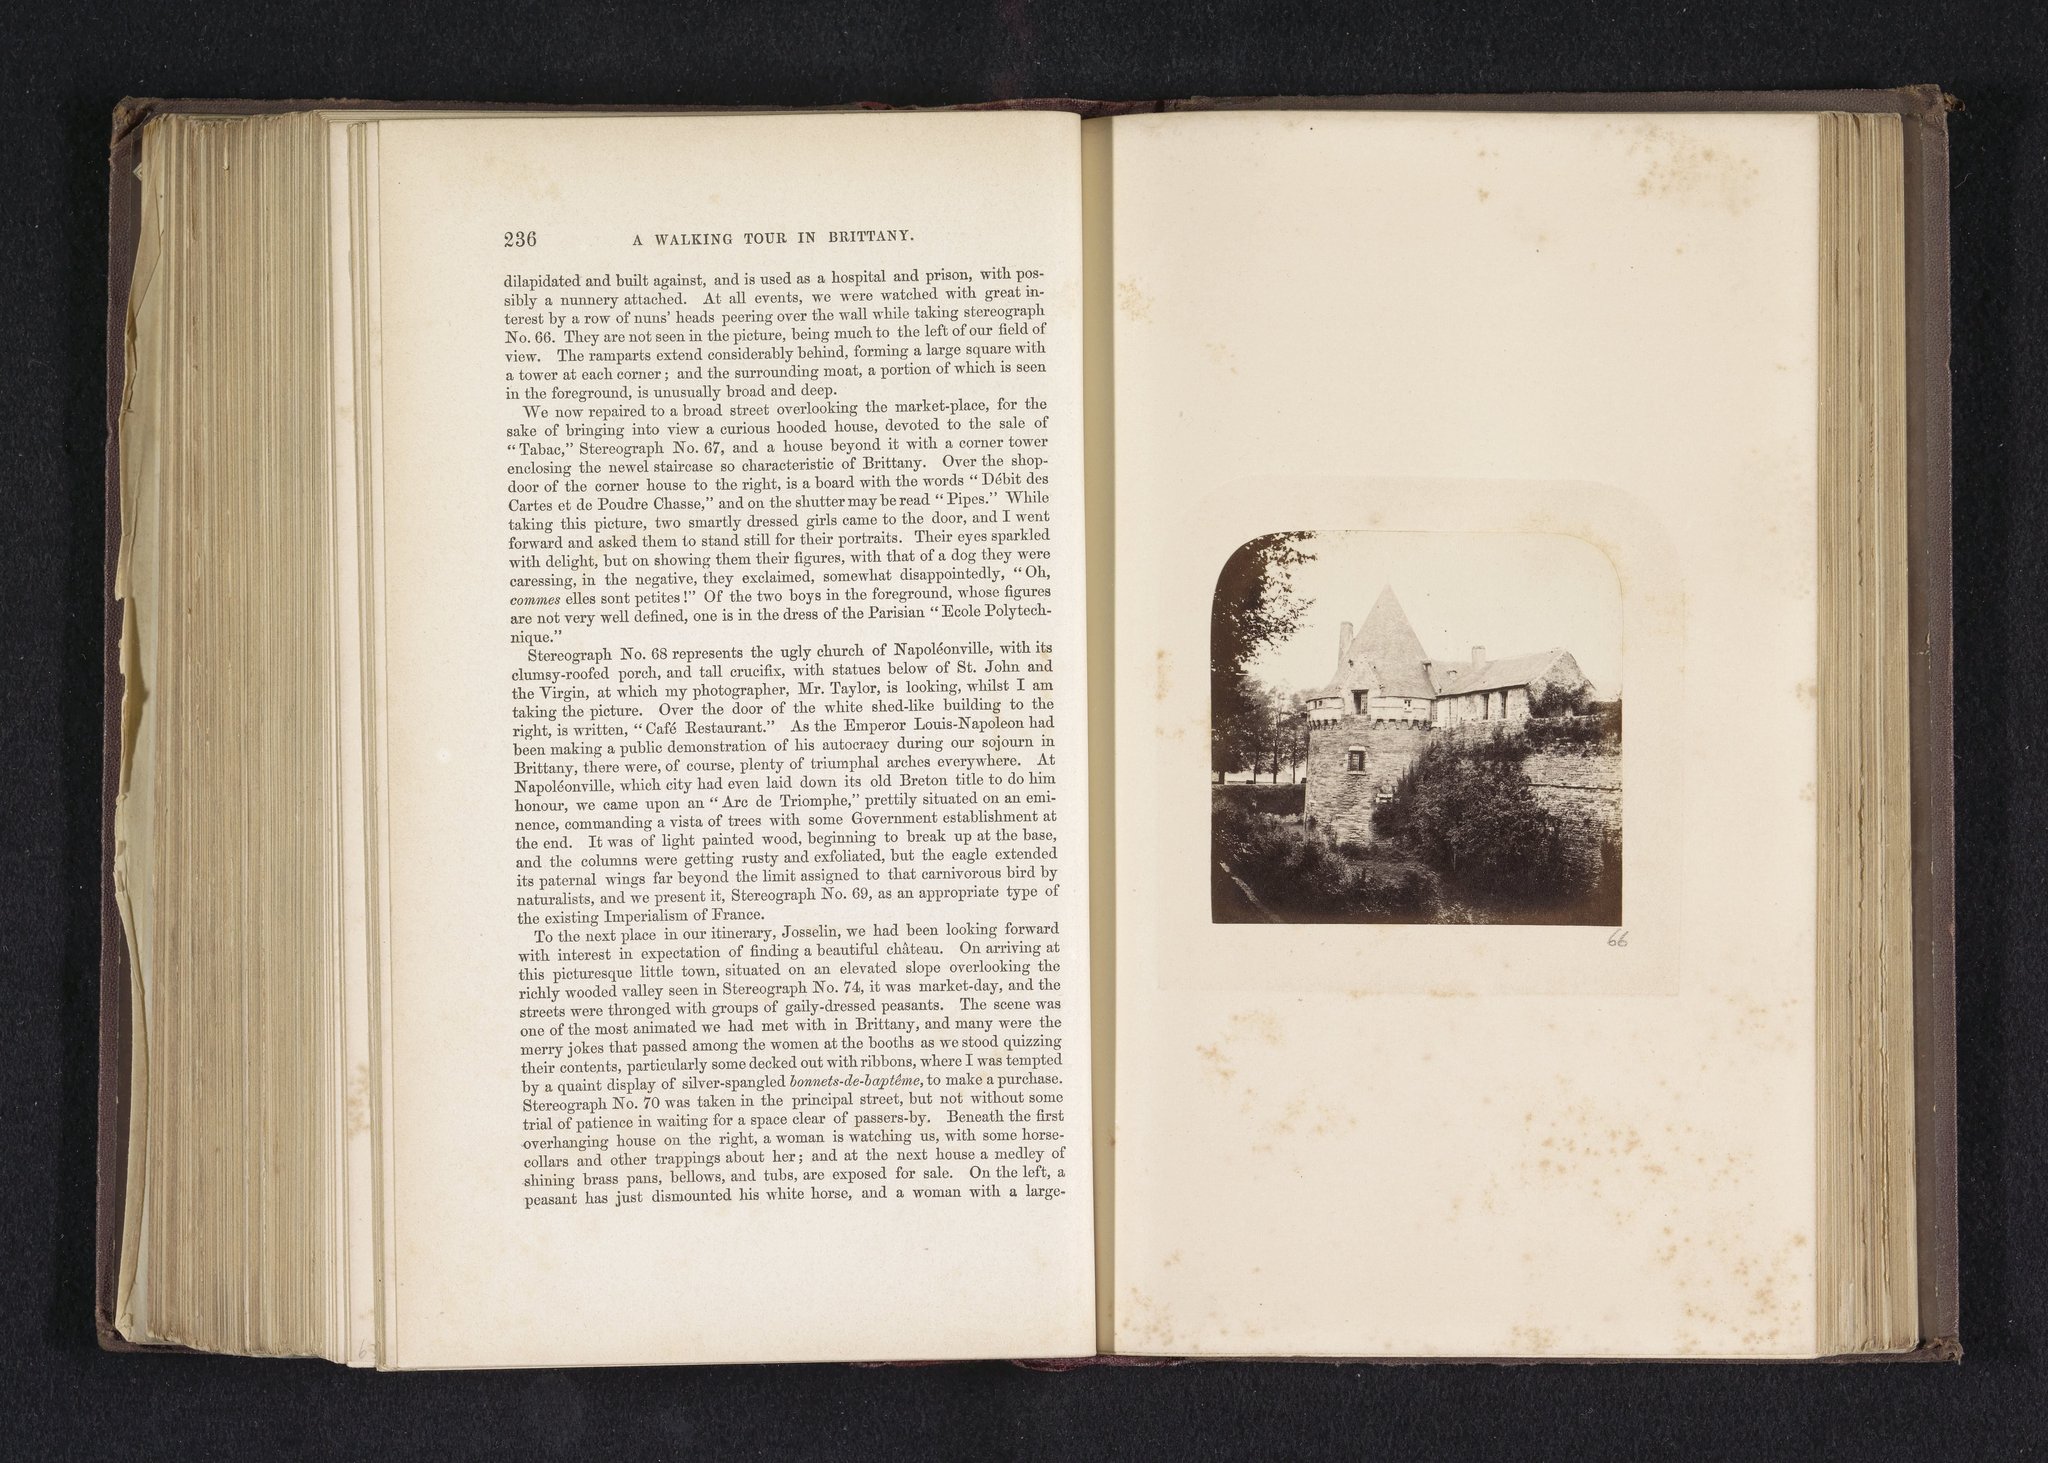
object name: page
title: Gezicht op het voormalige kasteel van de Prince de Léon in Napoléonville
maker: taylor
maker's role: fotograaf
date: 1850-1859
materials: photographic support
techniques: albumen print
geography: napoléonville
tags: castle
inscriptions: number: ‘66’